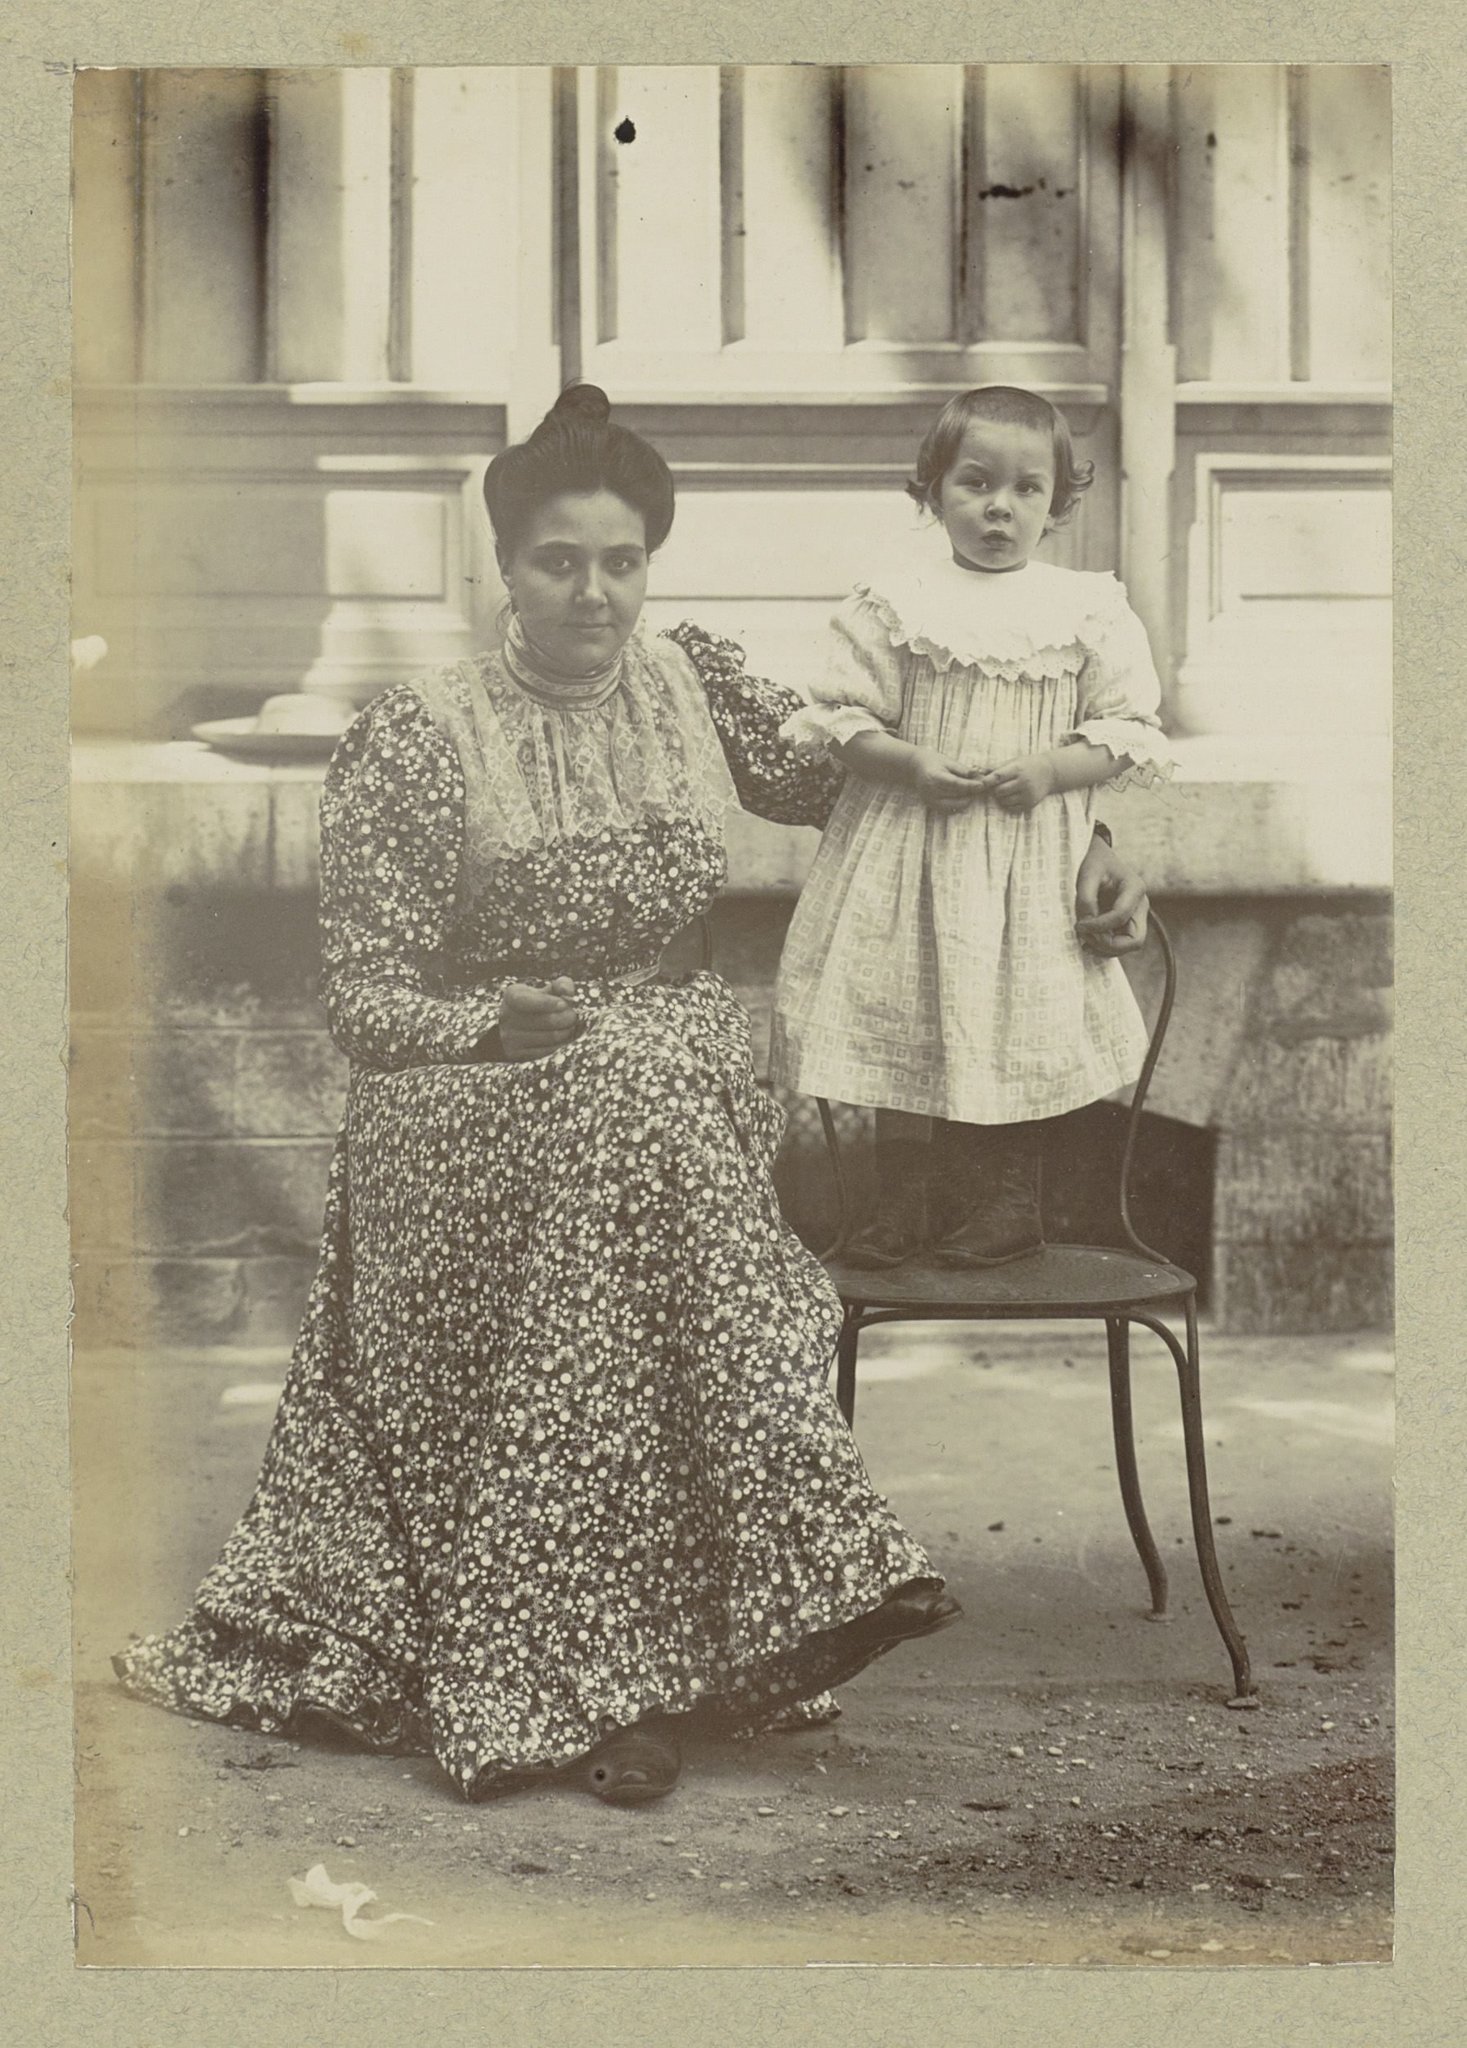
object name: photograph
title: Portret van een zittende vrouw met een kind staand op een stoel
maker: Anonymous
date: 1885-1914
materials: photographic support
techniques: gelatin silver print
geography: france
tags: mother and child(ren), woman and child(ren) (family group), france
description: Onderdeel van Fotoalbum met familiefoto's.